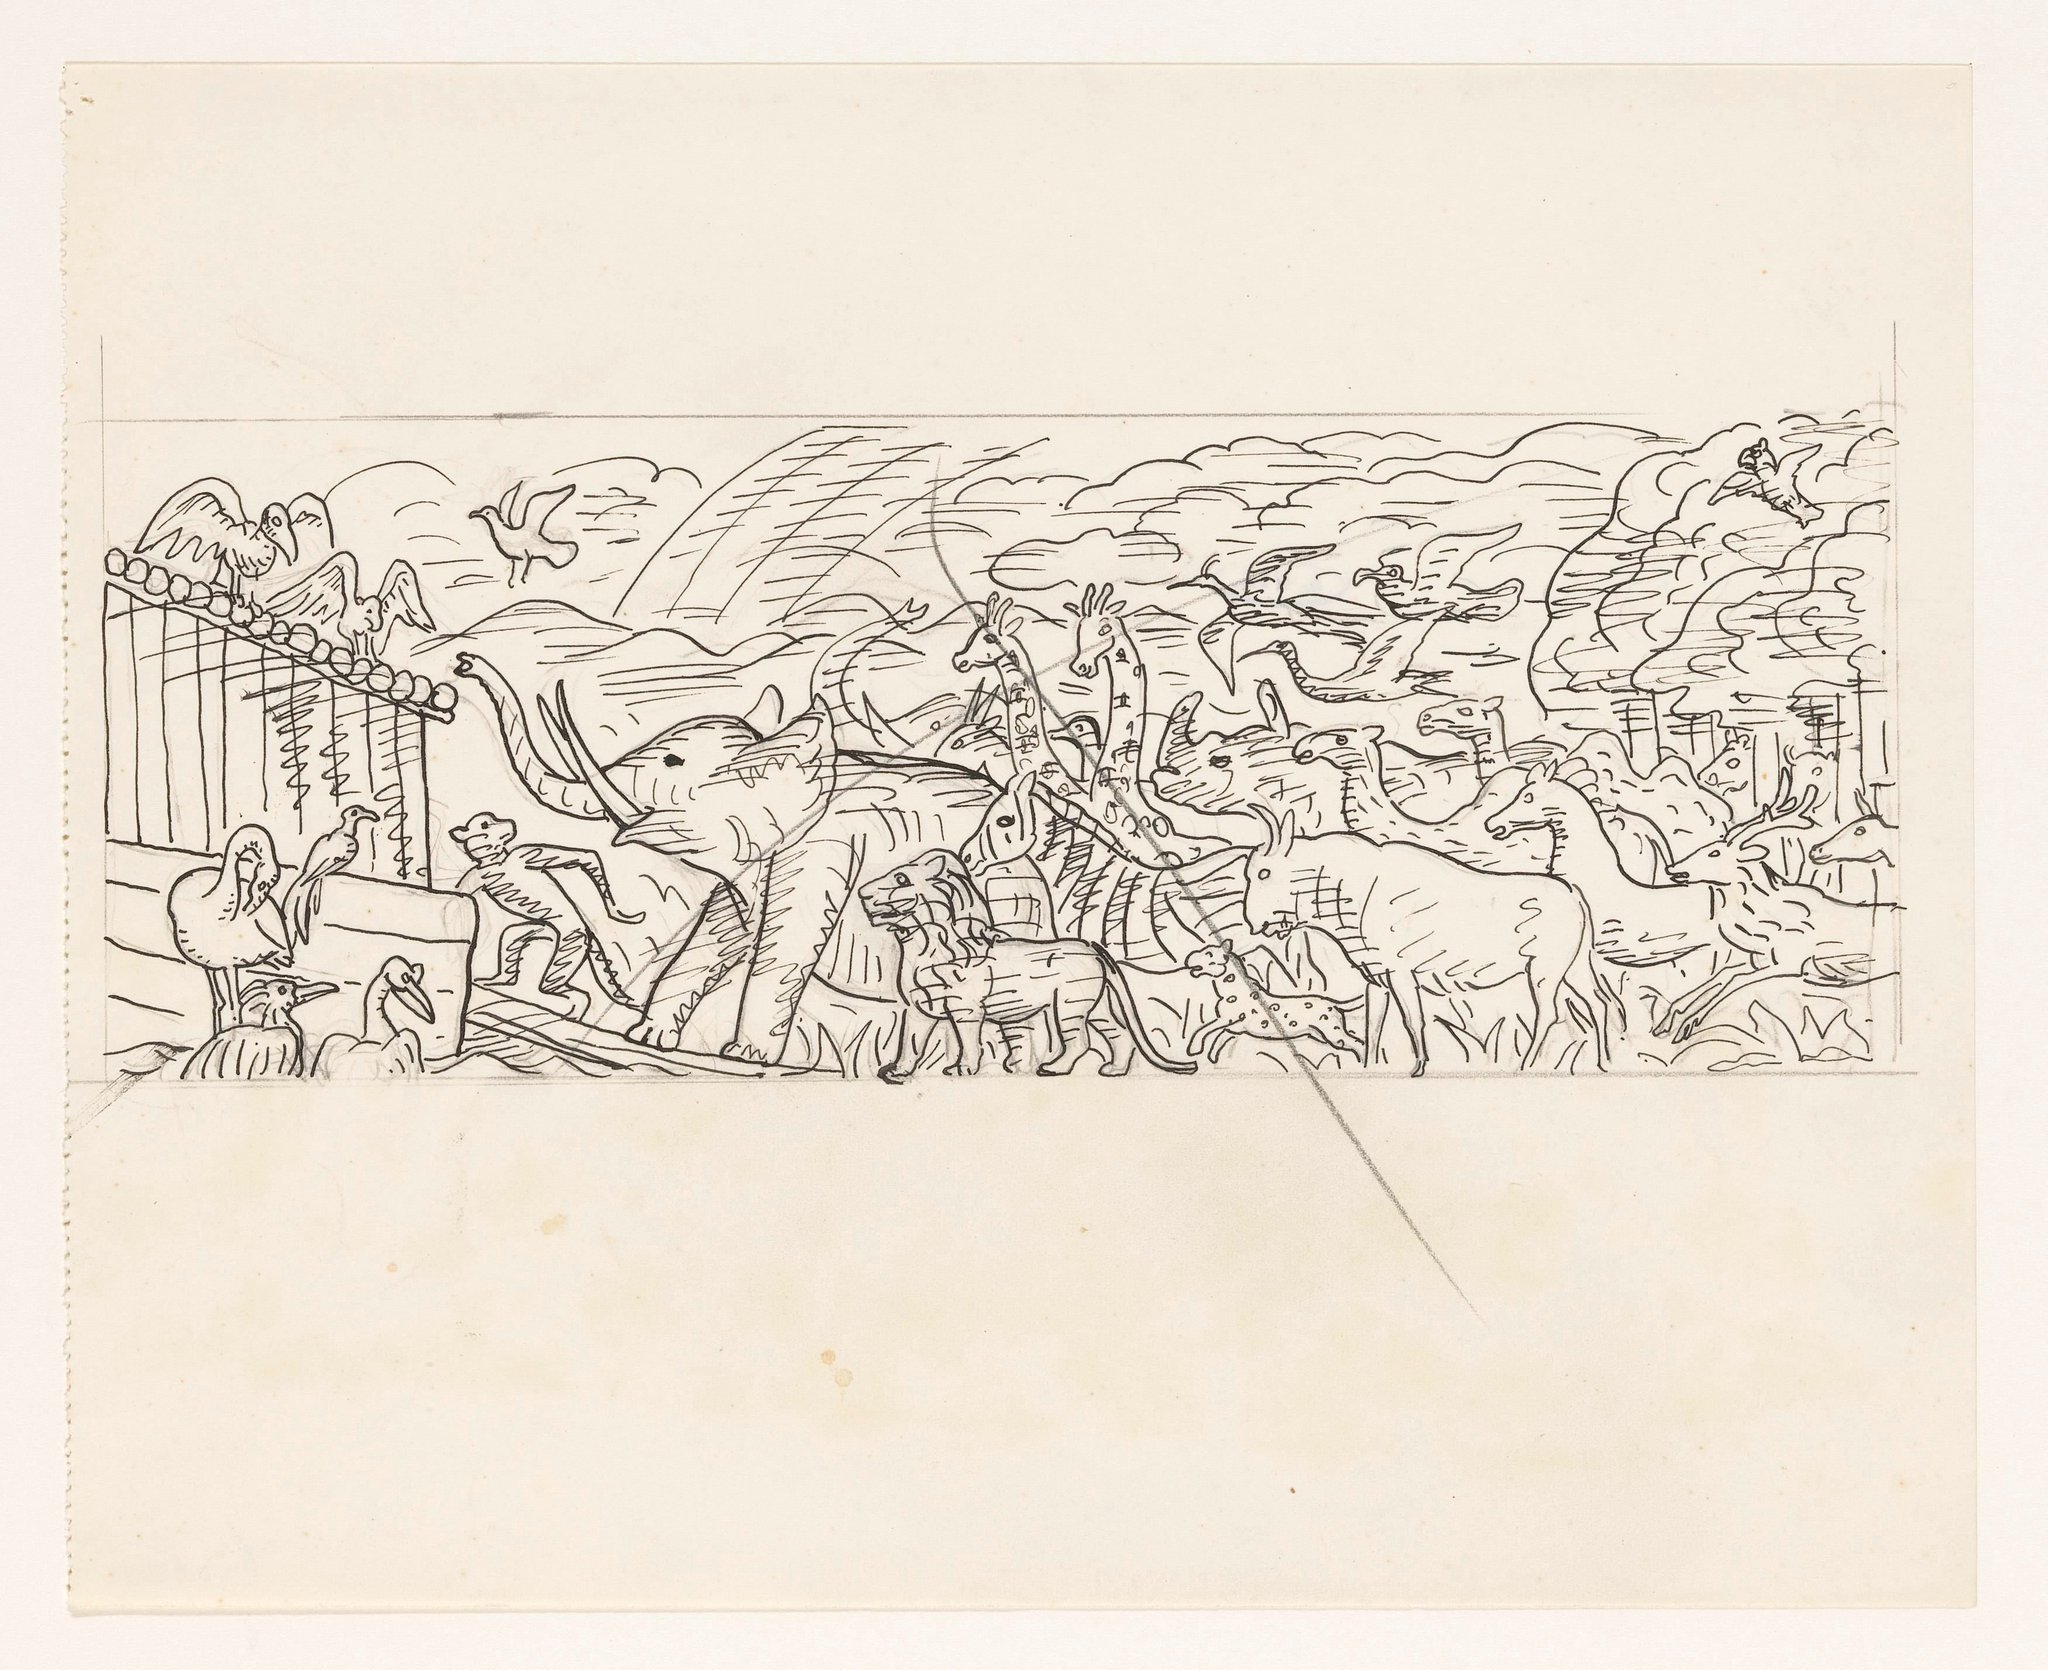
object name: drawing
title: Dieren die inschepen in de ark van Noach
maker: leo gestel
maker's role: draughtsman, print maker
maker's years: 1881-1941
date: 1891-1941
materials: ink, paper, pencil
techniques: pen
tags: the animals enter the ark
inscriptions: collector's mark: Lugt 2228